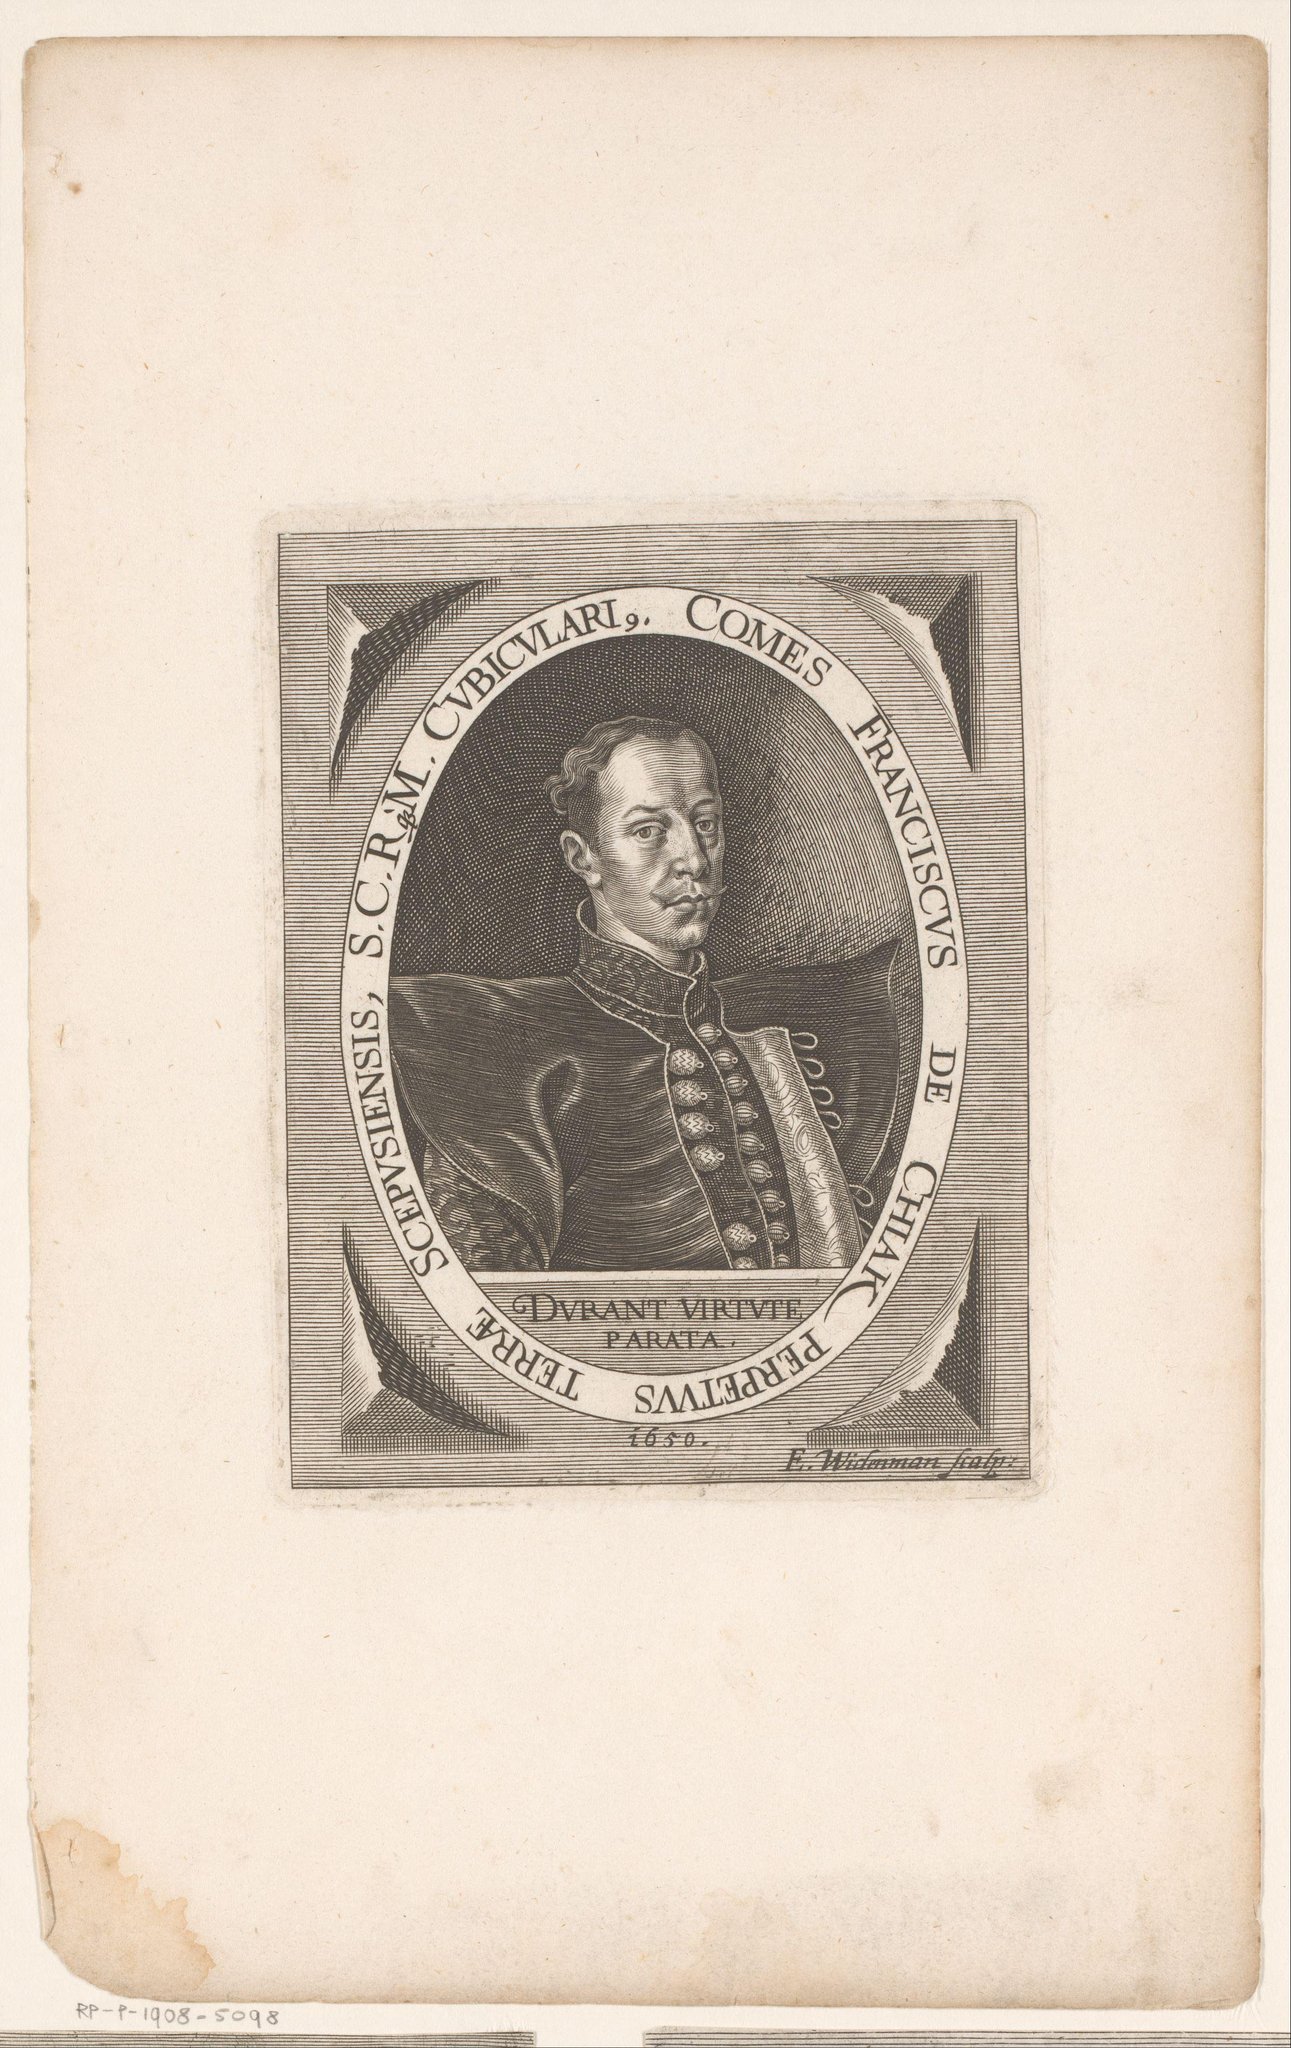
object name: print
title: Portret van Franciscus de Chiak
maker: elias widemann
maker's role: print maker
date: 1650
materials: paper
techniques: engraving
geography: vienna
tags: historical persons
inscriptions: collector's mark: Lugt 2228